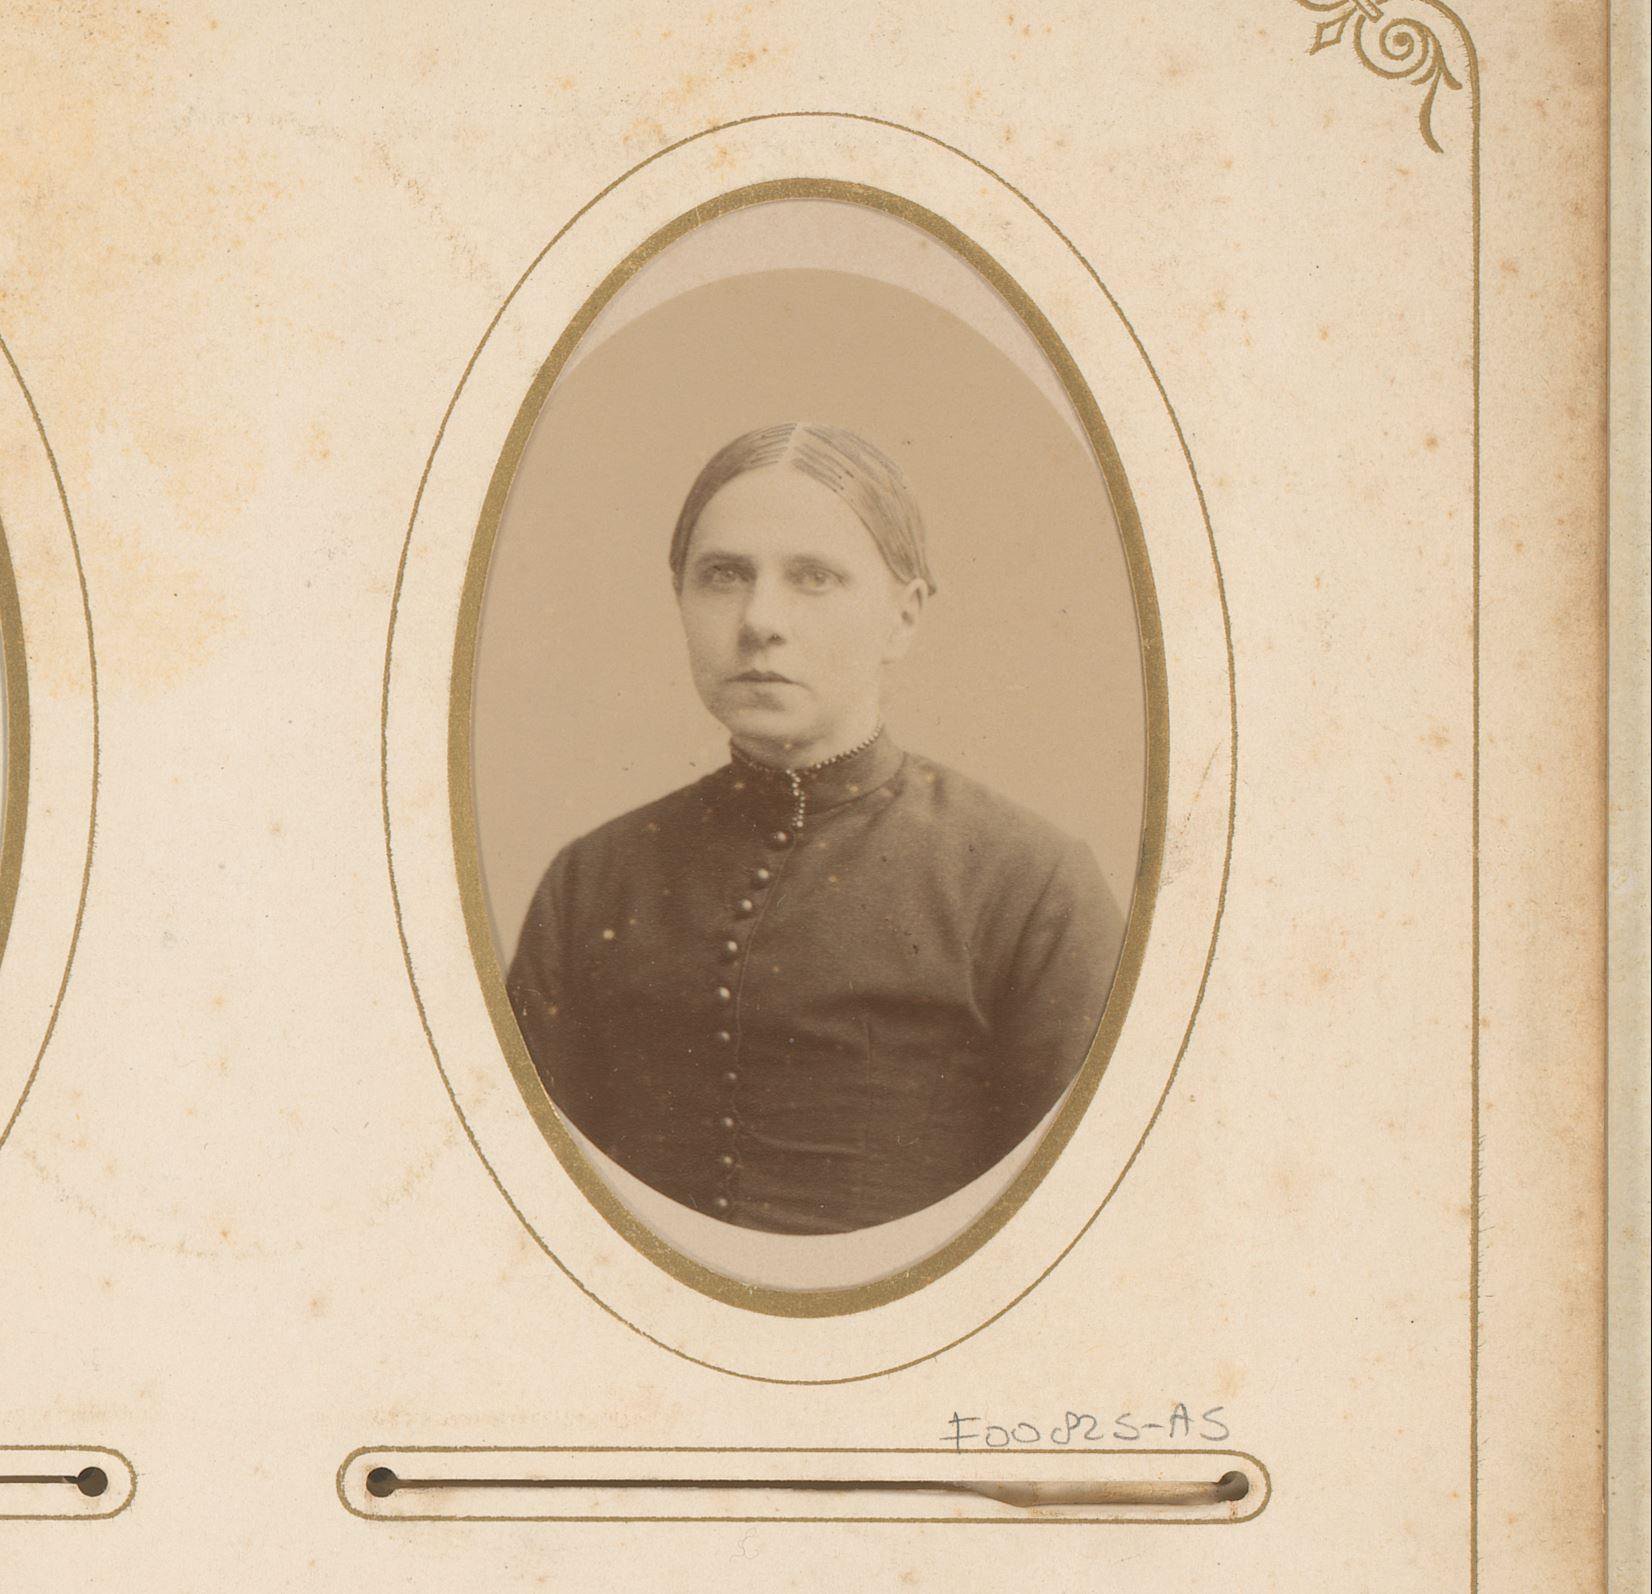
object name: carte de visite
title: Portret van een vrouw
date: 1881-1900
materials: cardboard, photographic support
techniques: albumen print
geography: haarlem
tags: historical persons - bb - woman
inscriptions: inscription: ‘(...)/ C.F. & L.J. Cordes/ Haarlem/ Groote Houtstraat 84/ 's Bosch a/d Parade./ Op verschillende tentoonstellingen bekroond voor Vergrootingen/ in kooldruk en andere photographien./ Met de hoogste onderscheiding op de Tentoonstelling van/ Kunstnijverheis te 's Hage/ De clichés blijven ter nabestelling bewaard./ Specialiteit in Kooldruk Vergrootingen.’